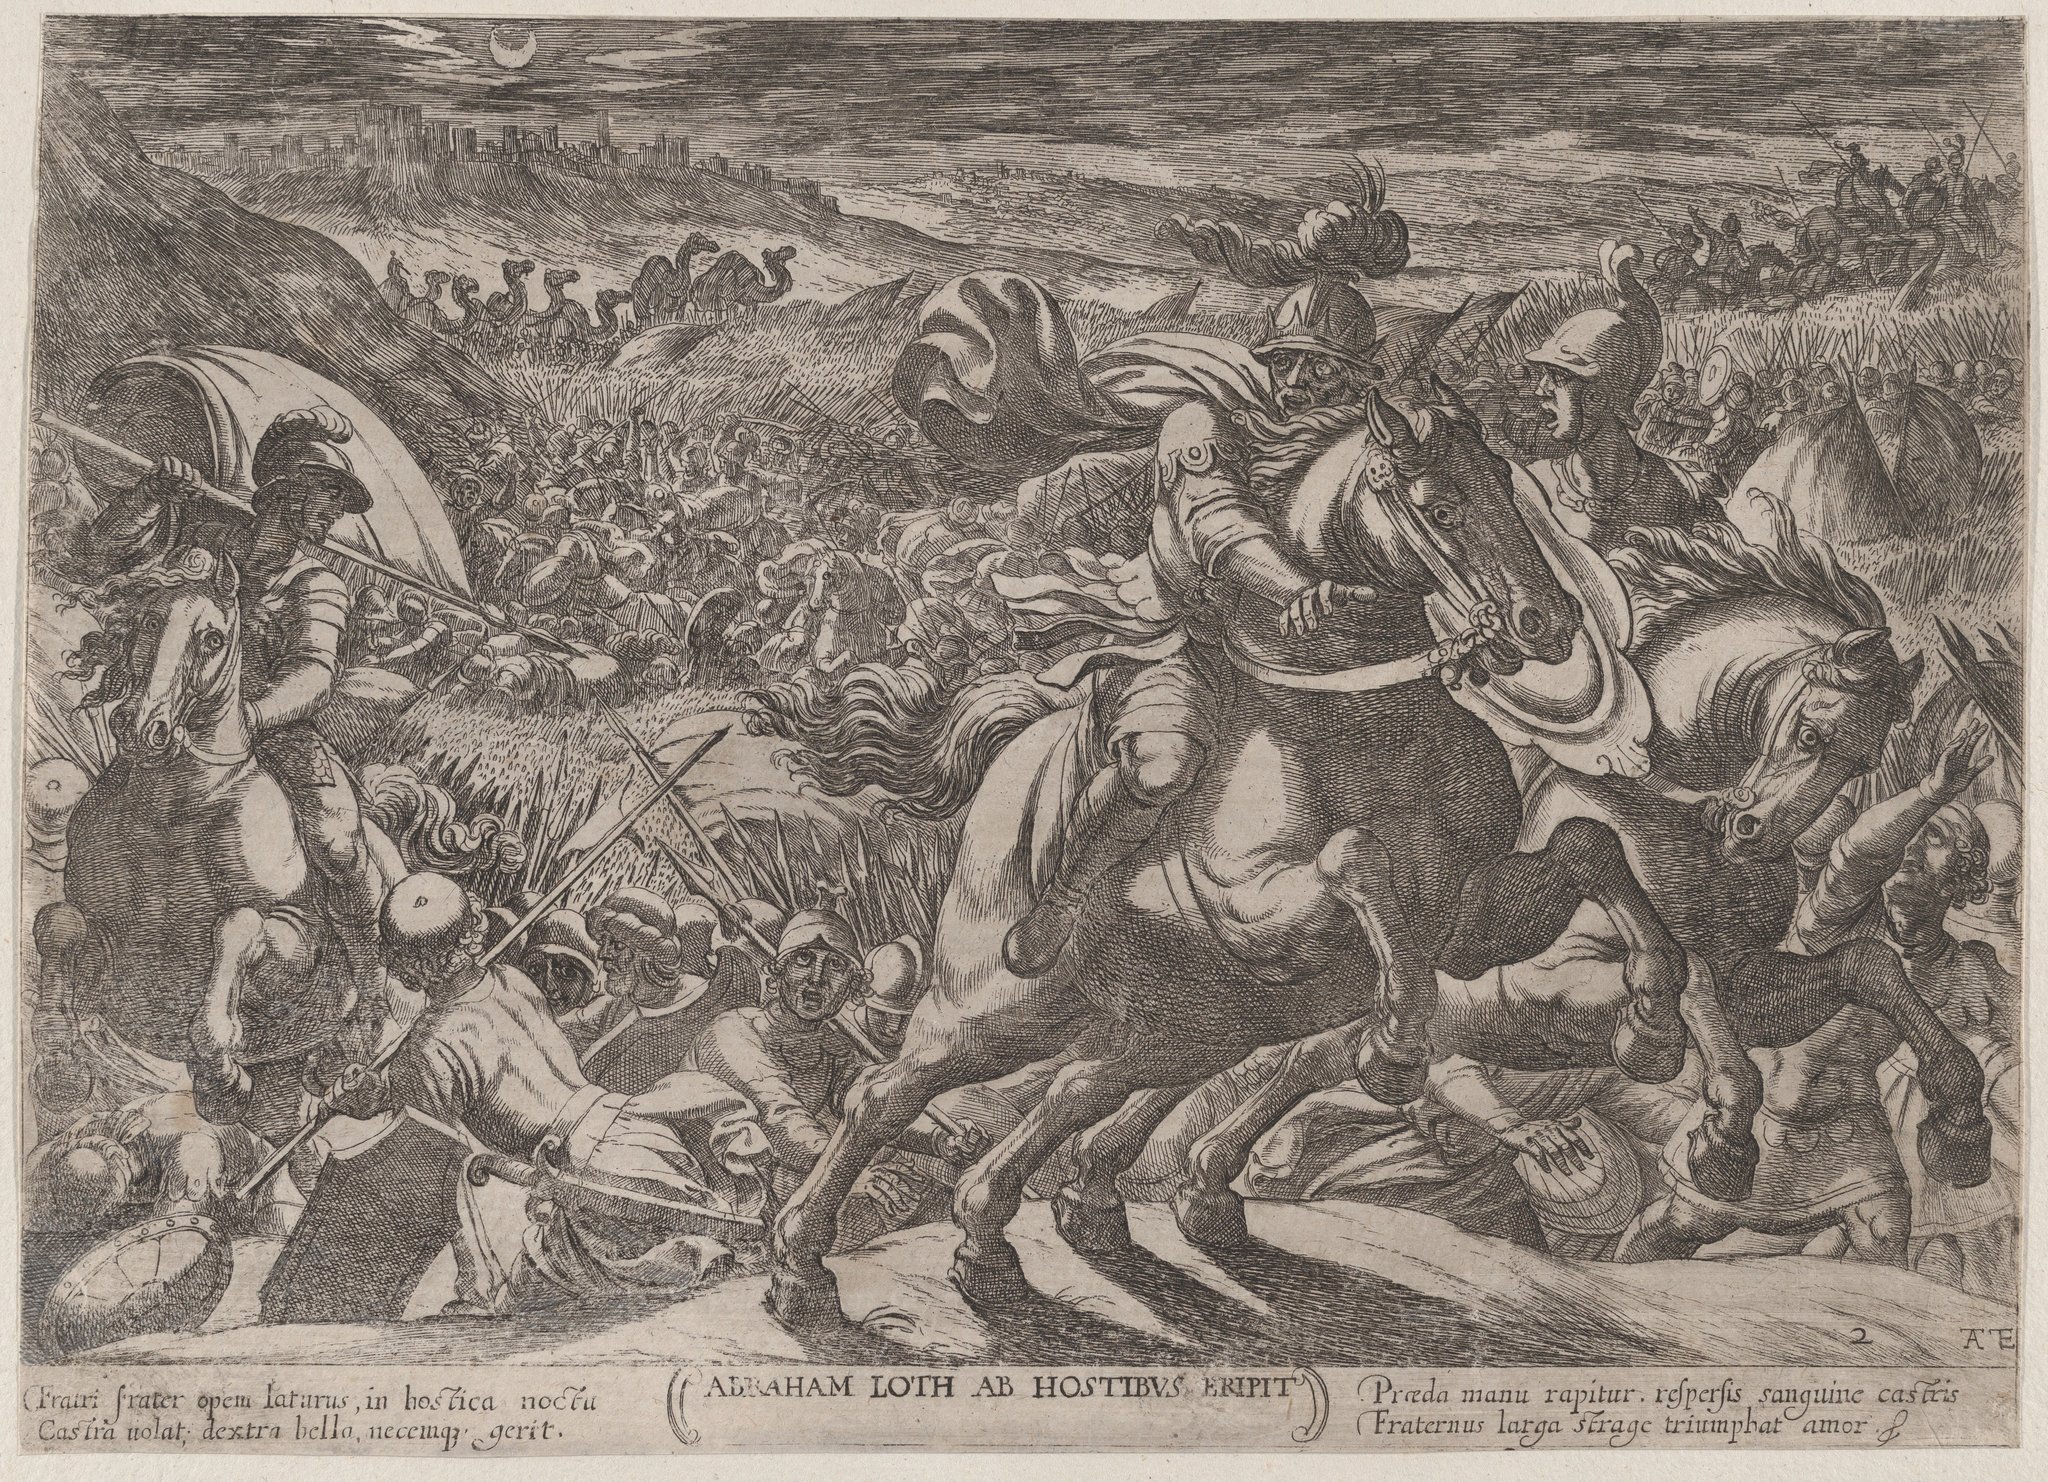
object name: print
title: Plate 2: Abraham Liberating His Nephew Lot, from "The Battles of the Old Testament"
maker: antonio tempesta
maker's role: artist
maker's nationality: italian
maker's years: 1555-1630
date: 1590-1610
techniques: etching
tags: battles,soldiers,horses,abraham